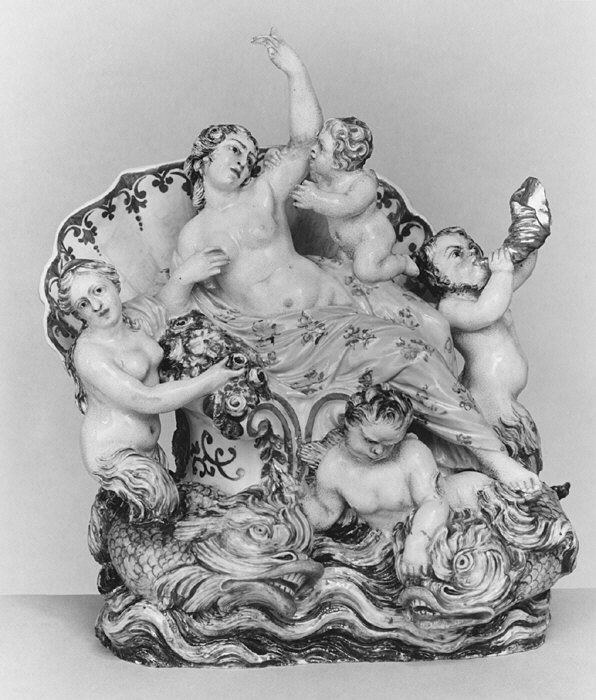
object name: group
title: Venus Rising From the Sea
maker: doccia porcelain manufactory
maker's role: manufactory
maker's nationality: italian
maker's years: 1737-1896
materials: hard paste porcelain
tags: female nudes,putti,venus,dolphins